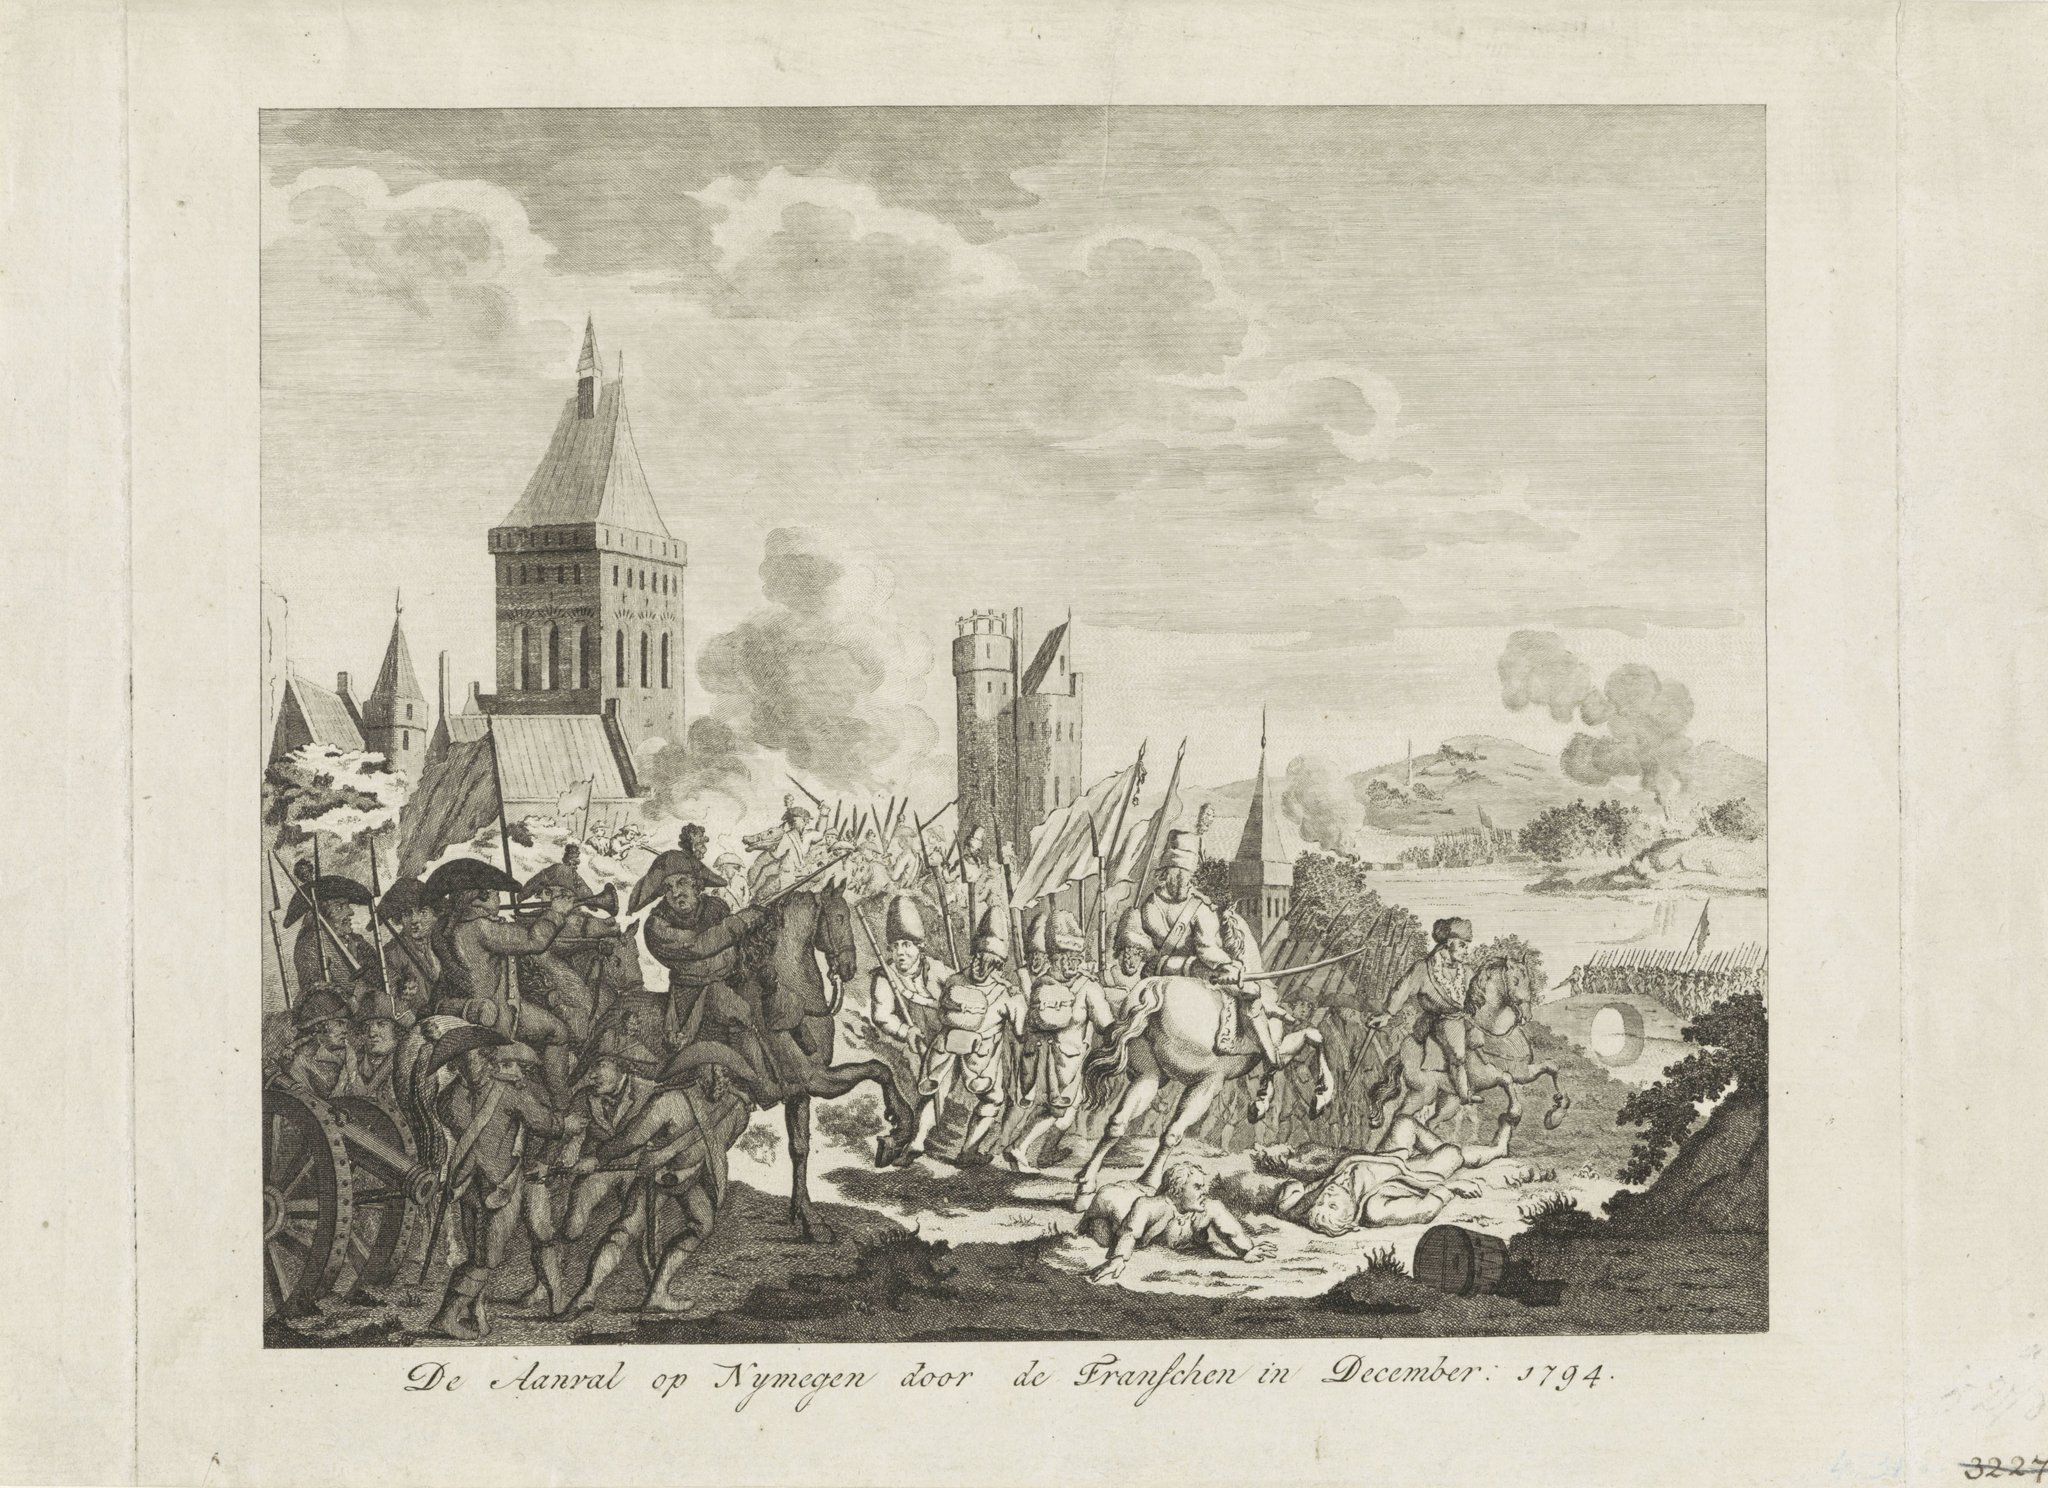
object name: print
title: De Aanval op Nymegen door de Franschen in December: 1794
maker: nicolaas sonnenberg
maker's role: draughtsman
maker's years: 1772-1822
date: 1794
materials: paper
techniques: etching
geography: northern netherlands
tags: breaking into city or fortress ~ siege, nijmegen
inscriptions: collector's mark: Lugt 2228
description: Franse troep dringen door de Molenpoort de stad Nijmegen binnen, 6-7 november 1794. Rechts in de verte de vertrekkende Britse troepen.